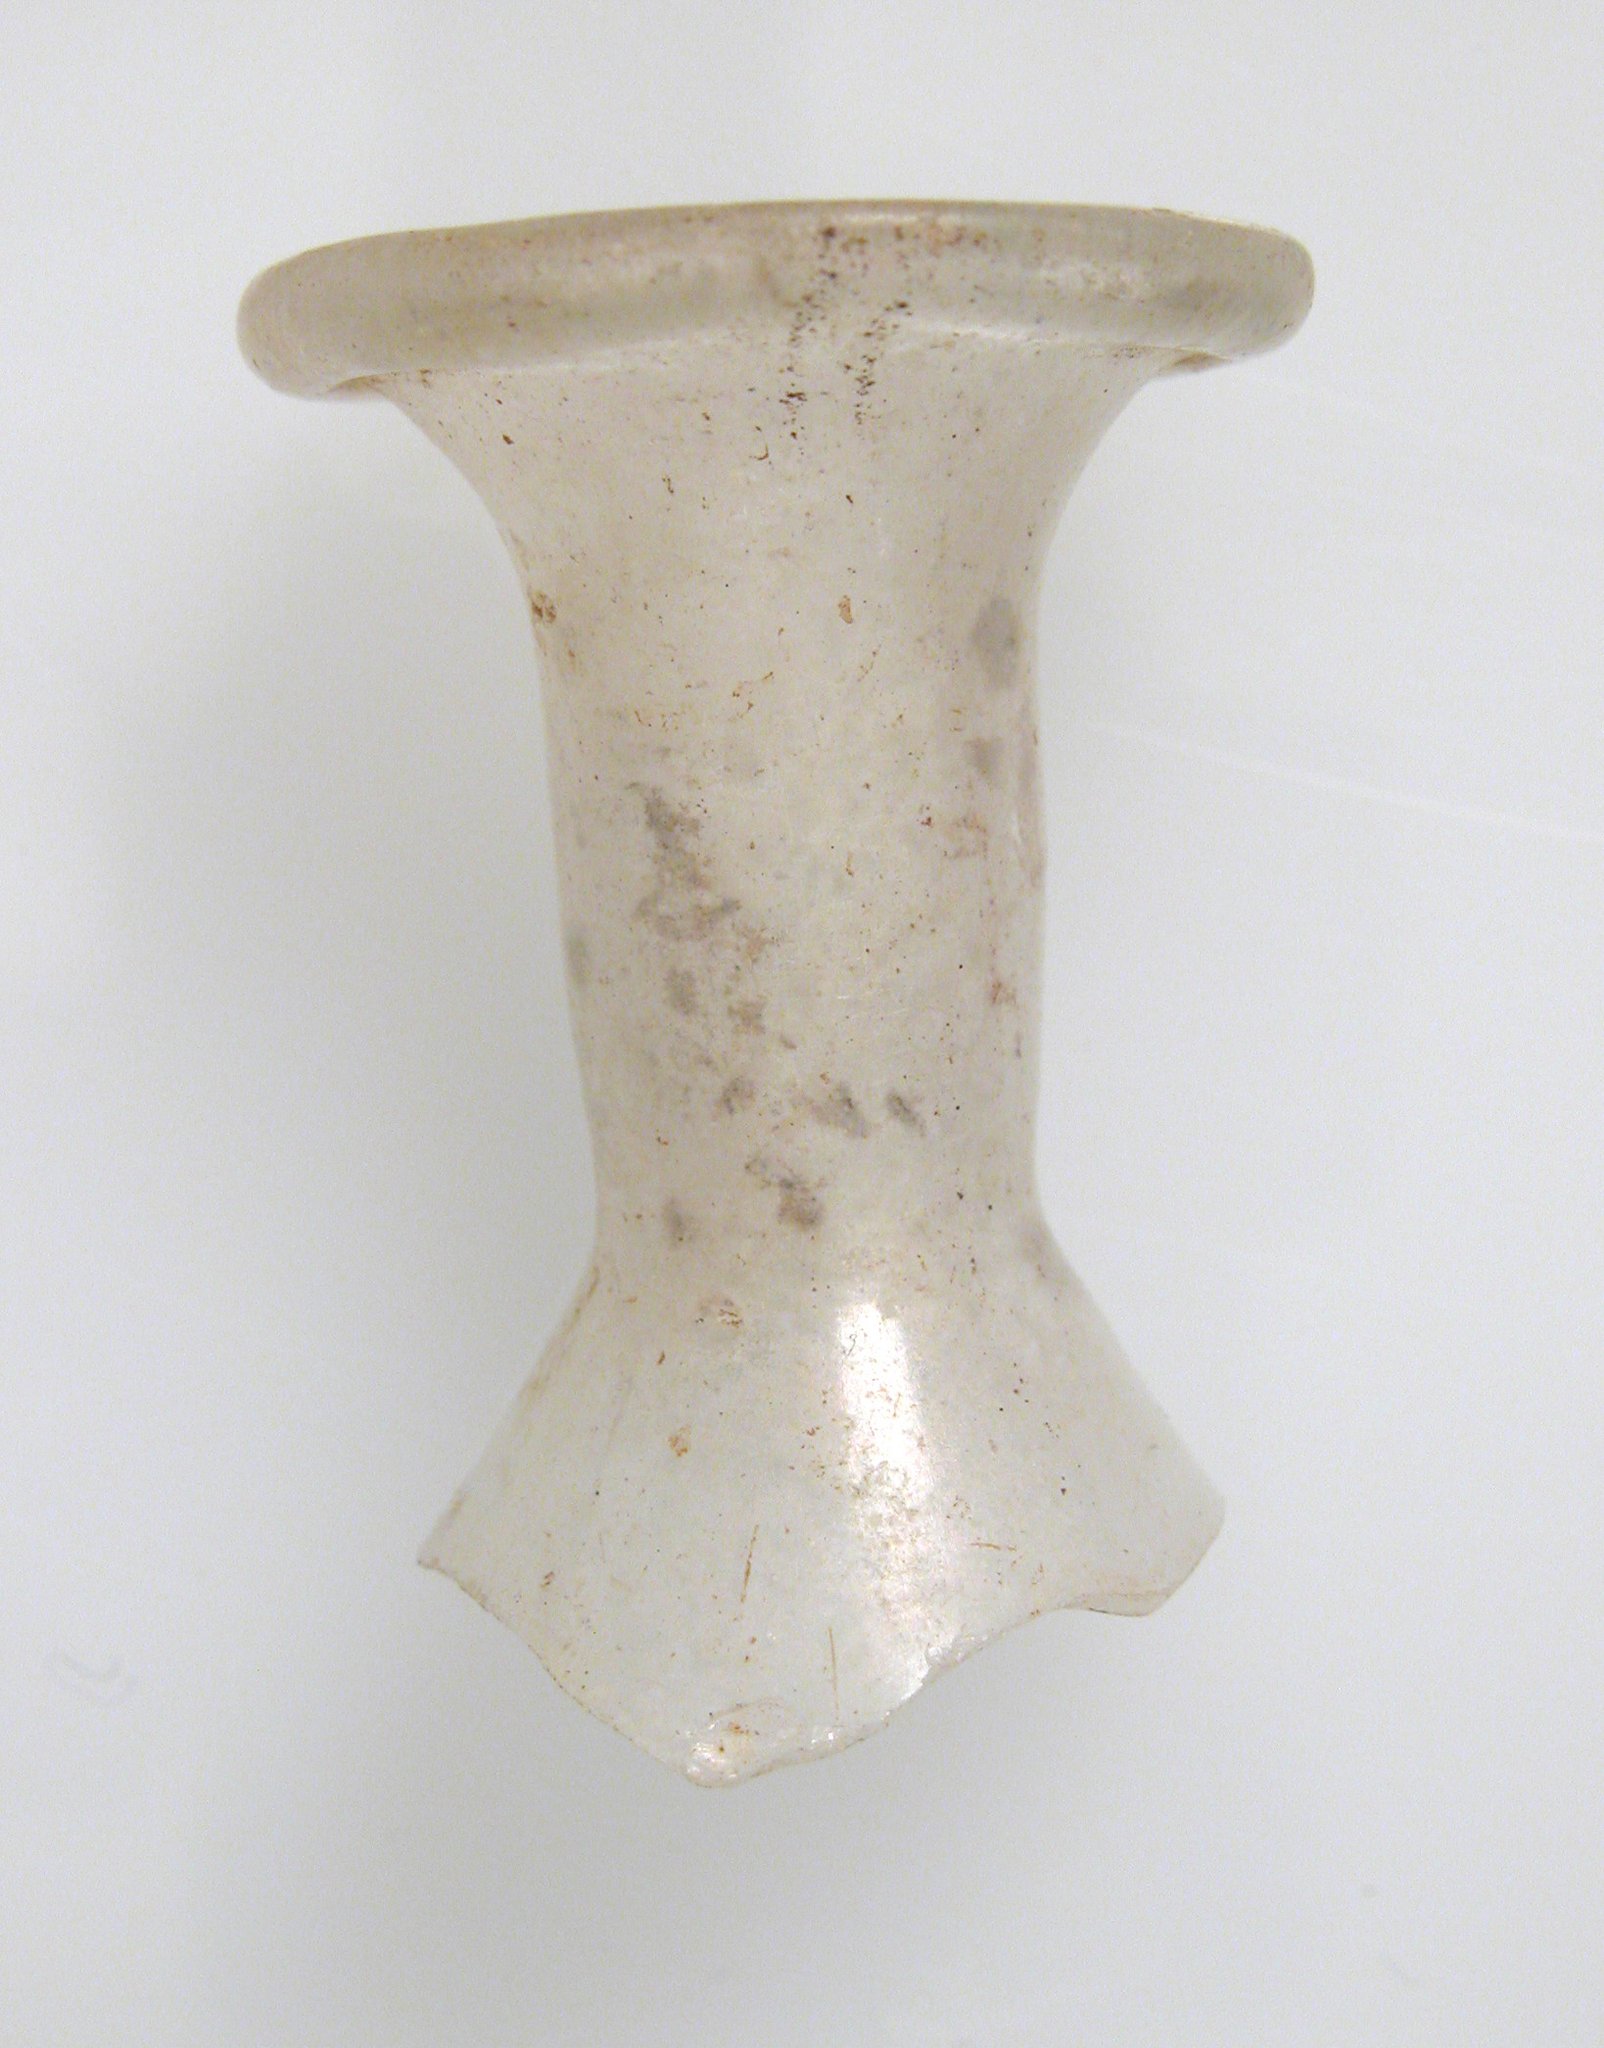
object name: fragment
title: Neck of a Bottle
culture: coptic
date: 301-433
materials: glass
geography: egypt